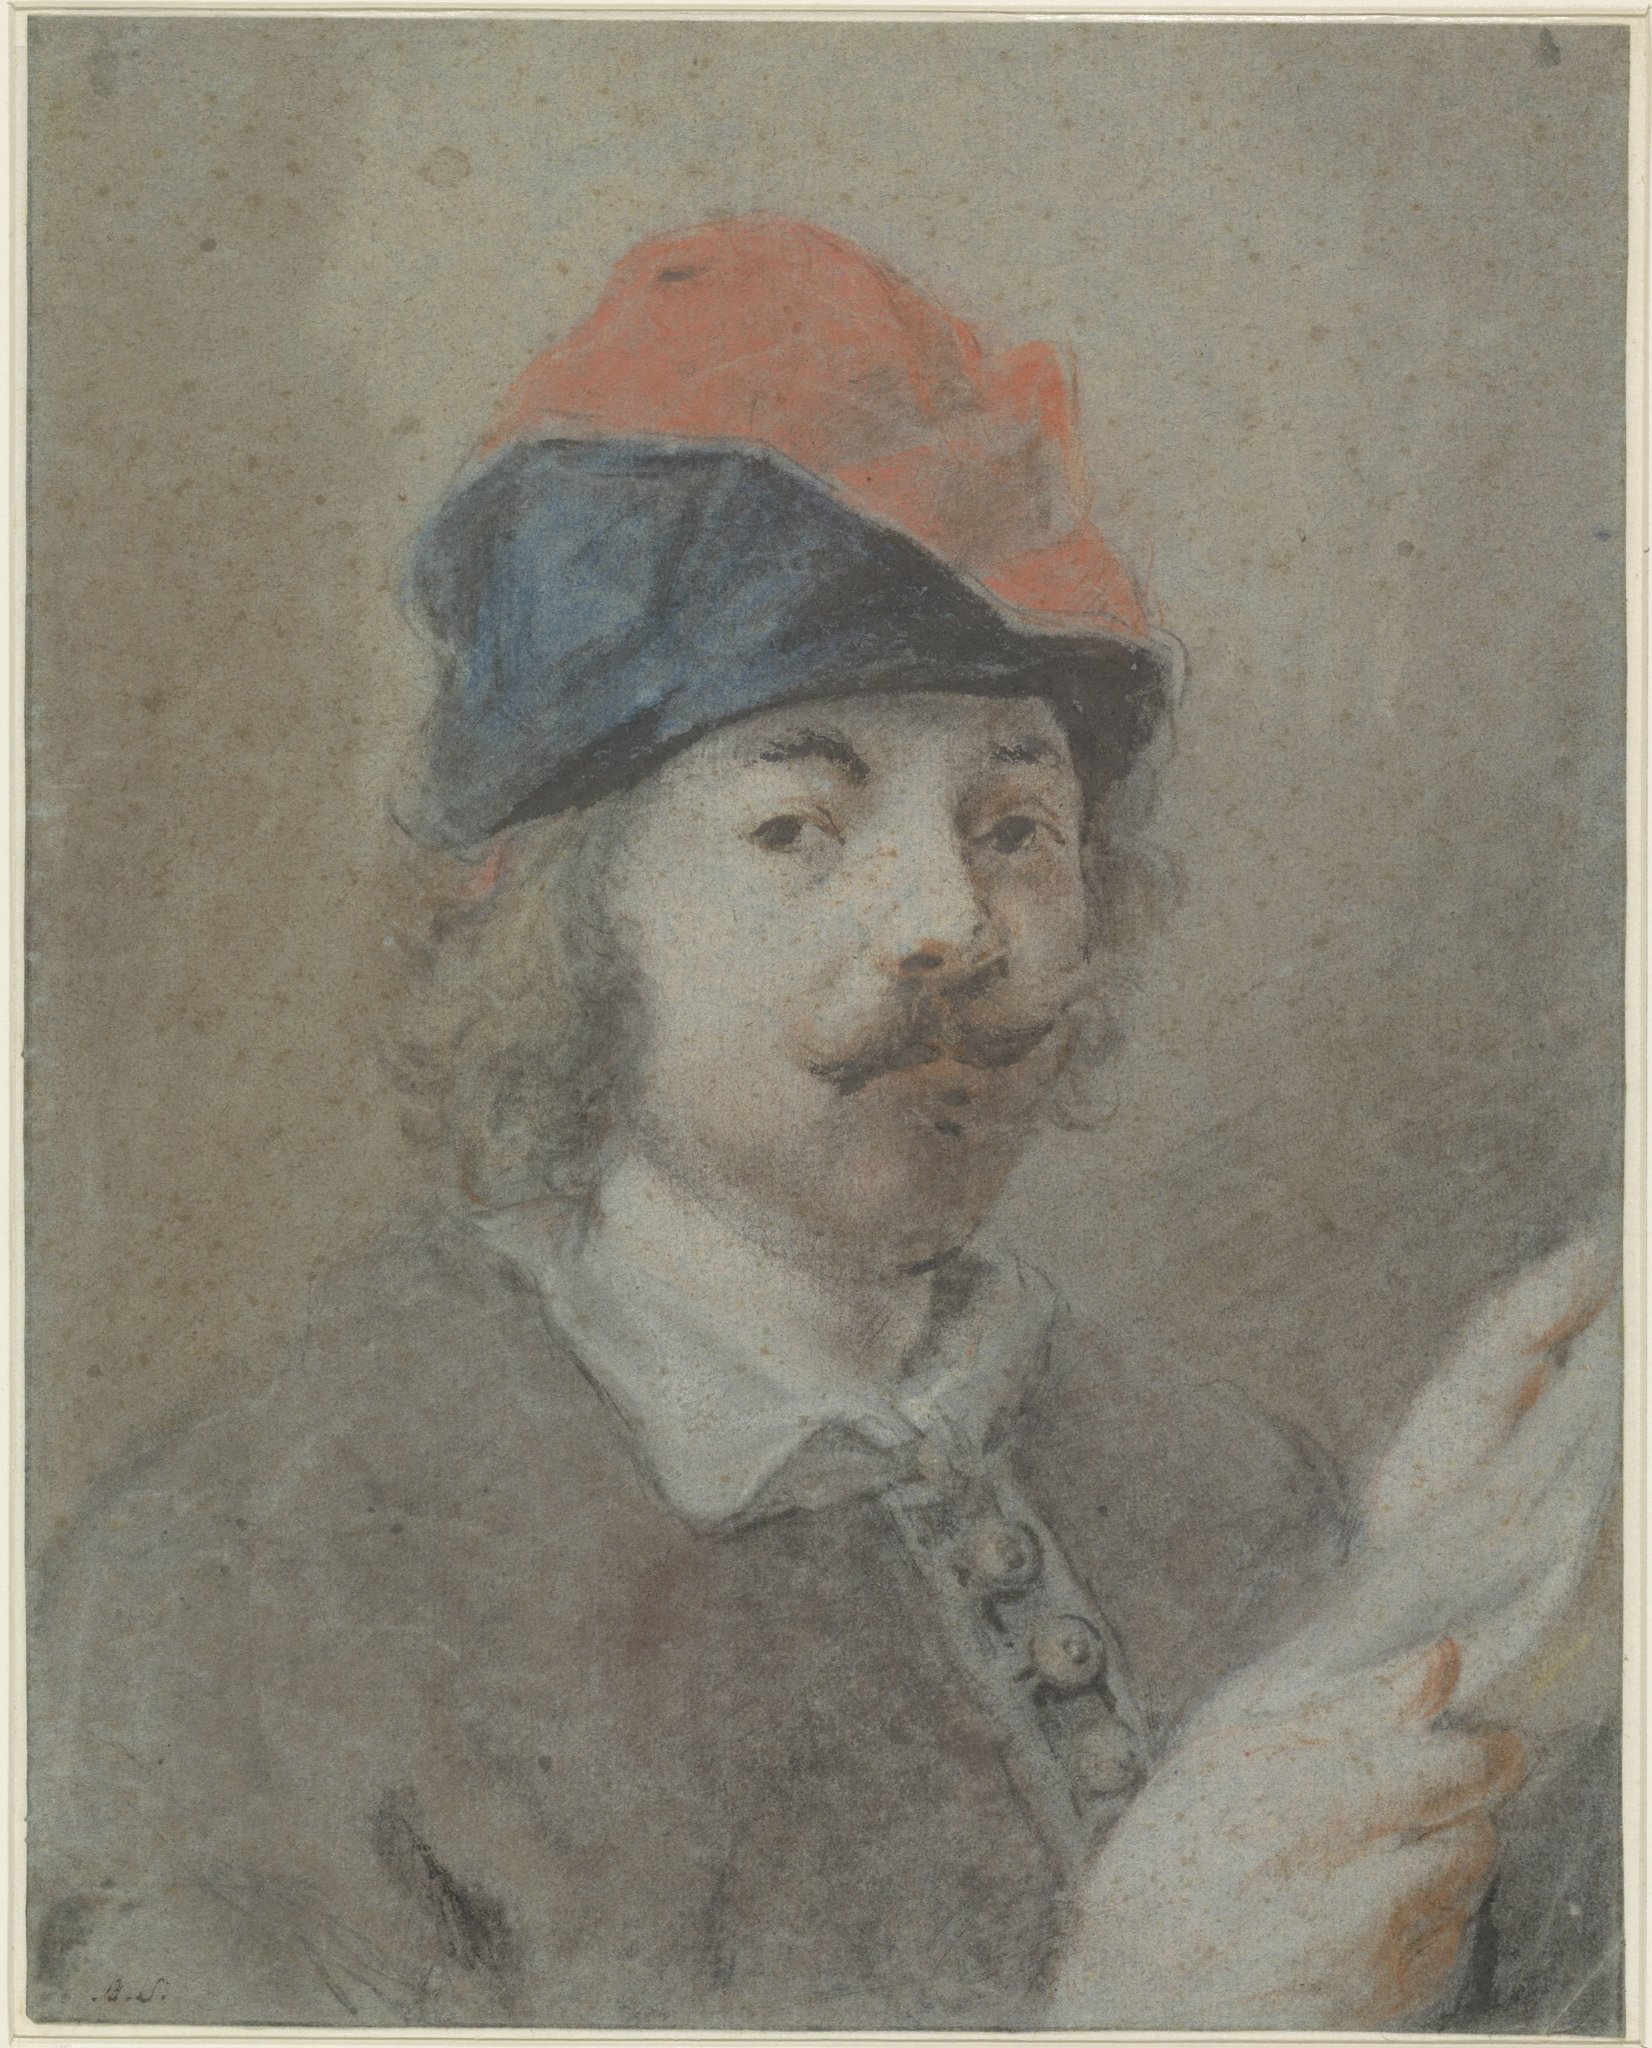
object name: drawing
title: Portret van Jacques Jordaens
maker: martinus schouman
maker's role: draughtsman, painter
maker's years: 1770-1848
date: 1780-1848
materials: chalk, paper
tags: antwerp, painter, print maker, draughtsman, designer, jacques jordaens, historical persons, portrait, self-portrait of painter, portrait, self-portrait of artist